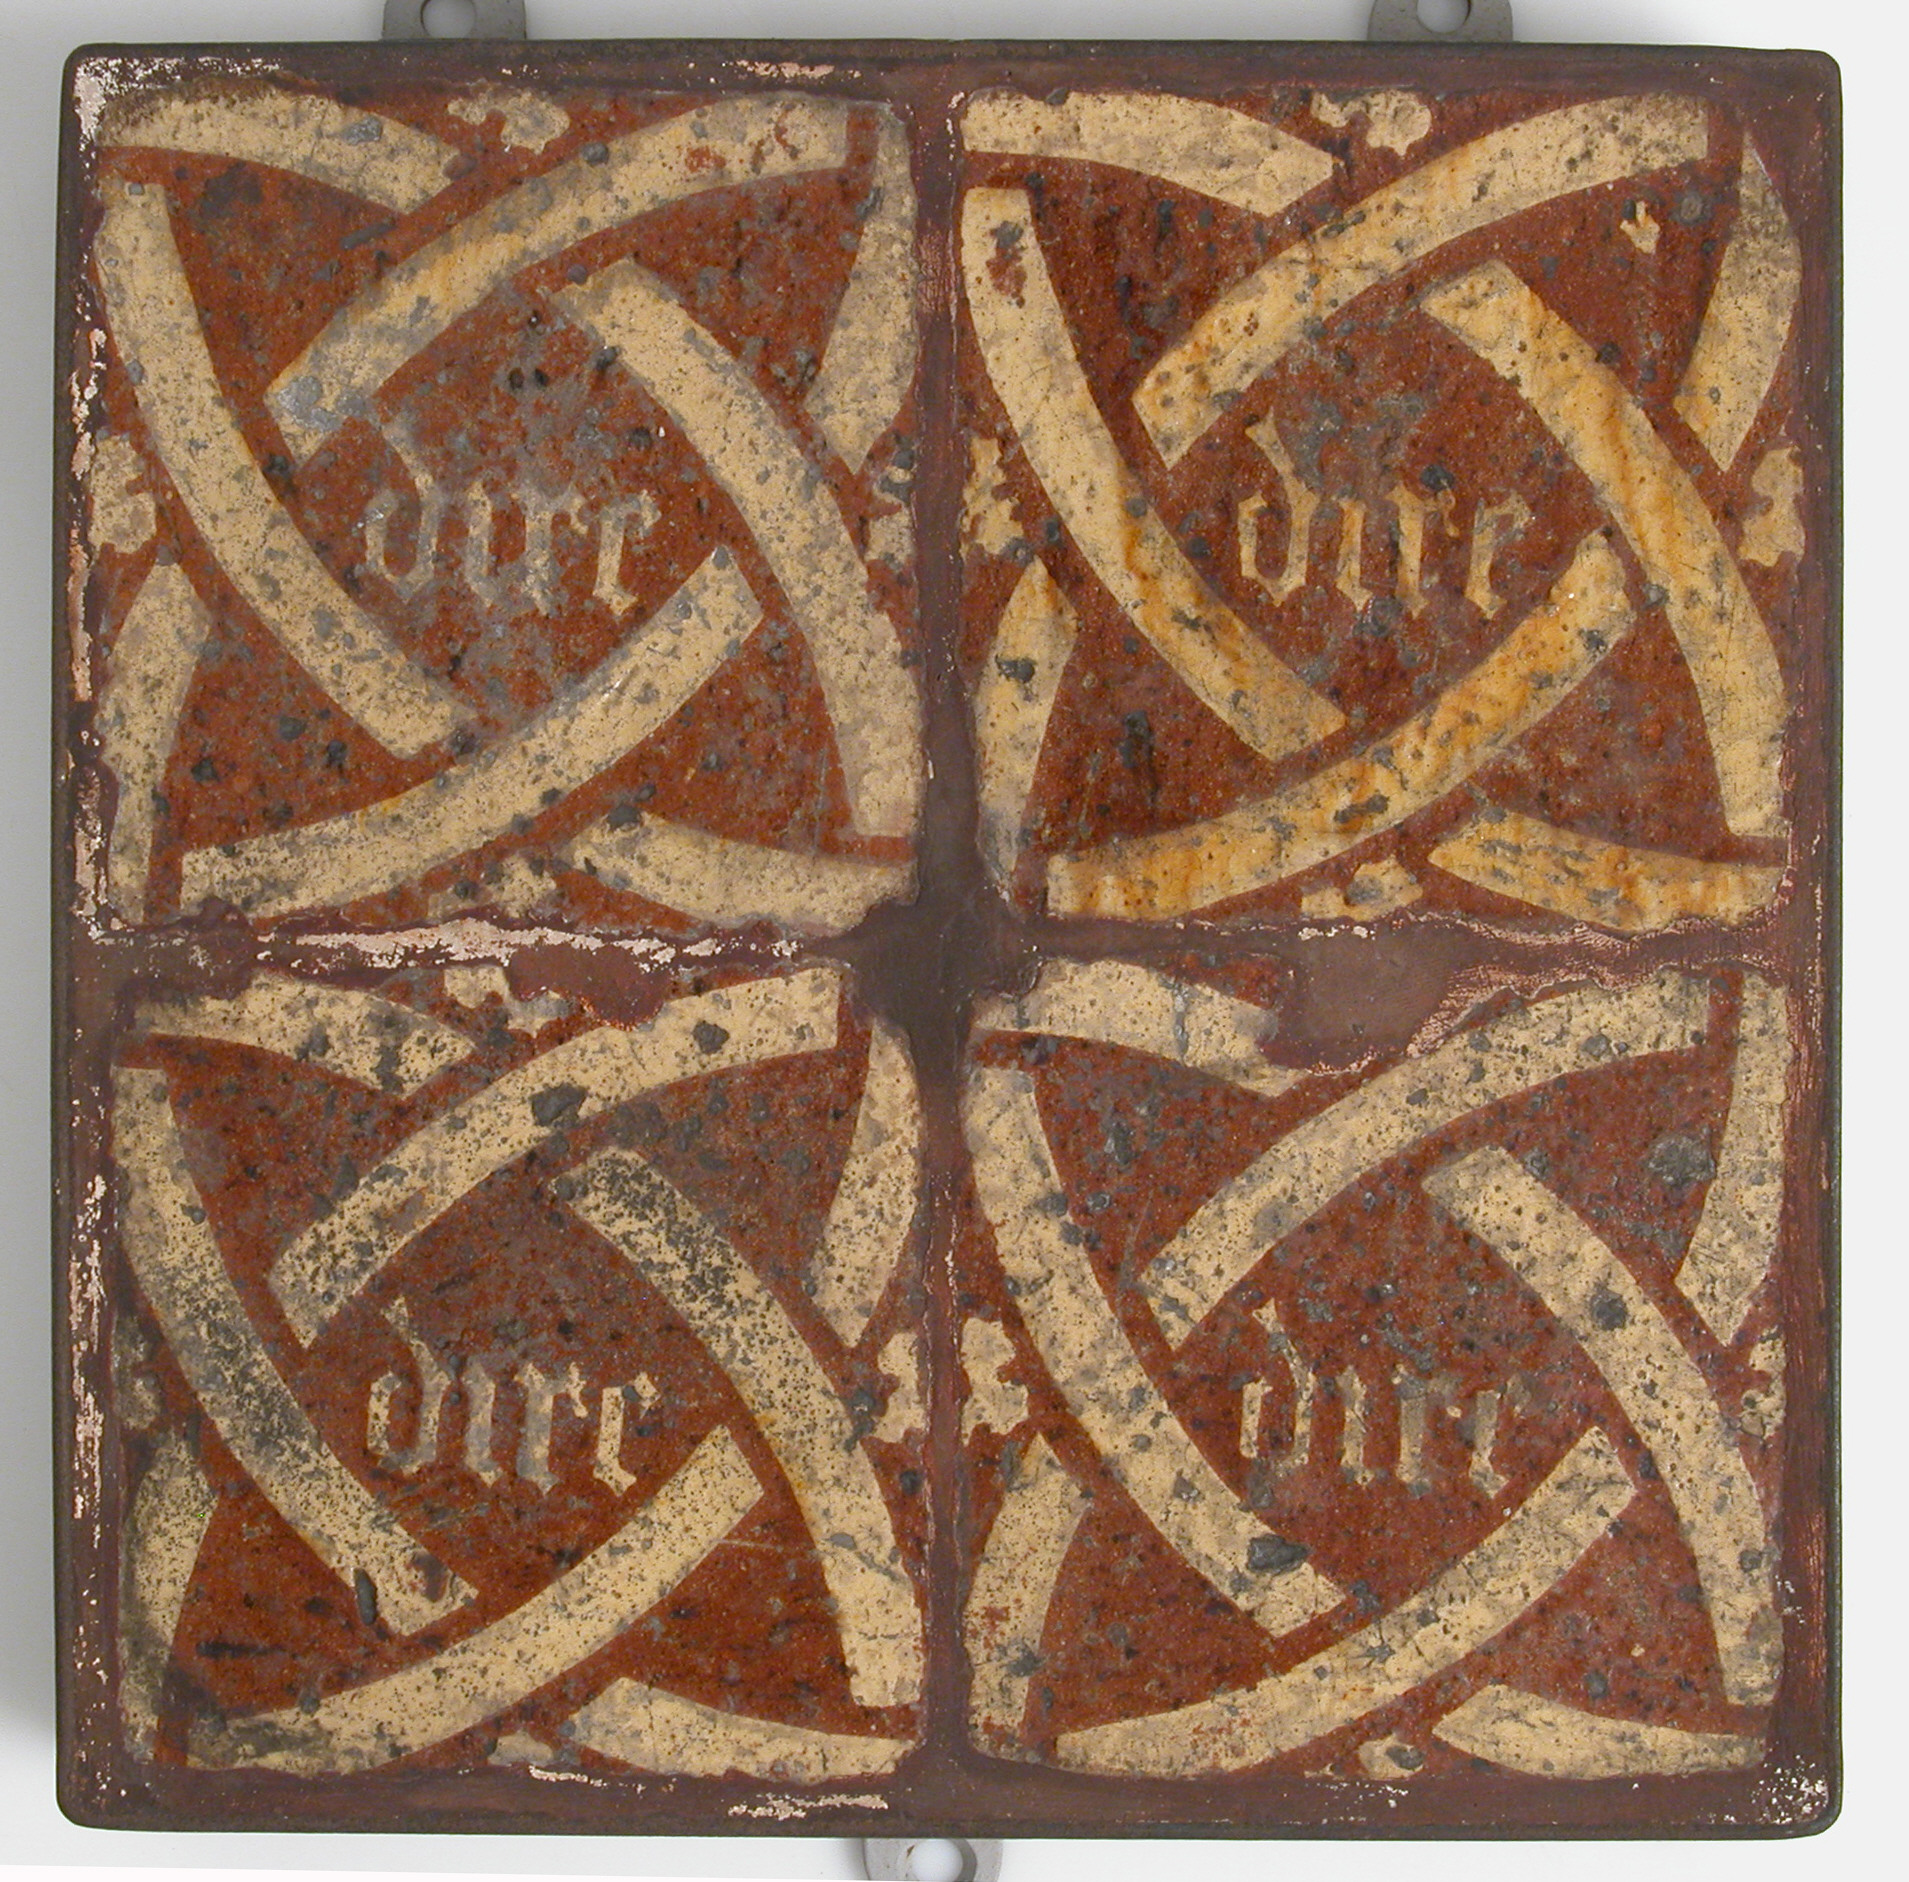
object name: tile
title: Tiles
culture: dutch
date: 1301-1500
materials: earthenware, glaze